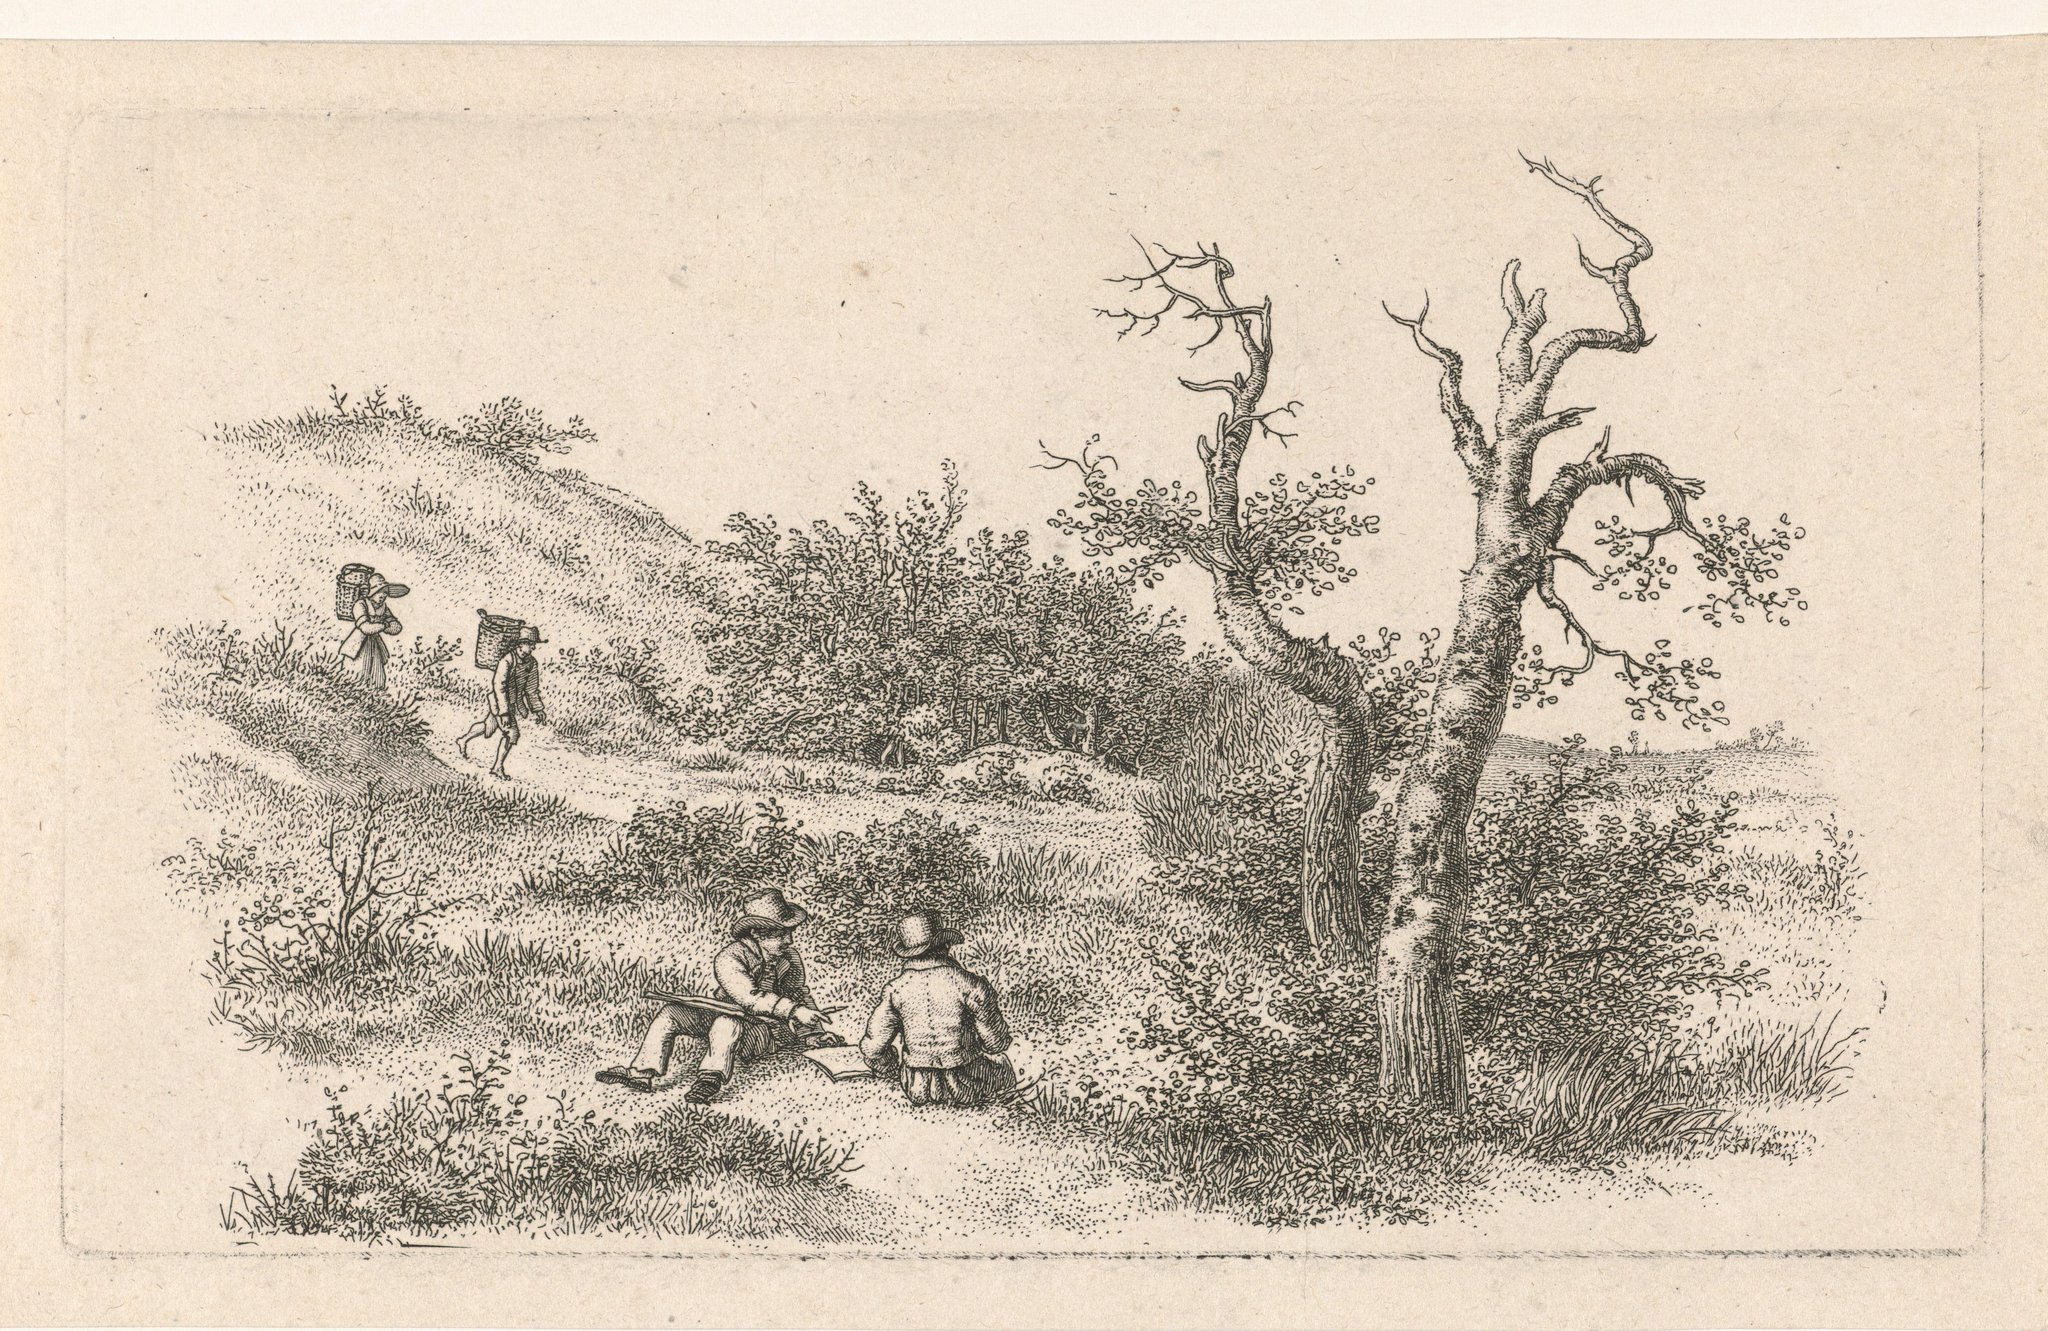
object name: print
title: Tekenaars in een duinlandschap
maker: jacob ernst marcus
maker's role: draughtsman, print maker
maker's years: 1774-1826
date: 1807-1814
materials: paper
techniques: etching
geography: amsterdam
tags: artist (in general) (+ out of doors), carrying something in basket, bag, rucksack, etc., draughtsman at work - cc - out of doors, dunes (sea not visible); in the dunes (+ landscape with figures, staffage)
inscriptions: collector's mark: Lugt 2228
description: Serie voor het eerst uitgegeven door Jacob Ernst Marcus onder de titel Studiebeelden en Fragmenten. Amsterdam: ca.1816. Later heruitgegeven als: Studie-prentwerk/ Etudes gravées.